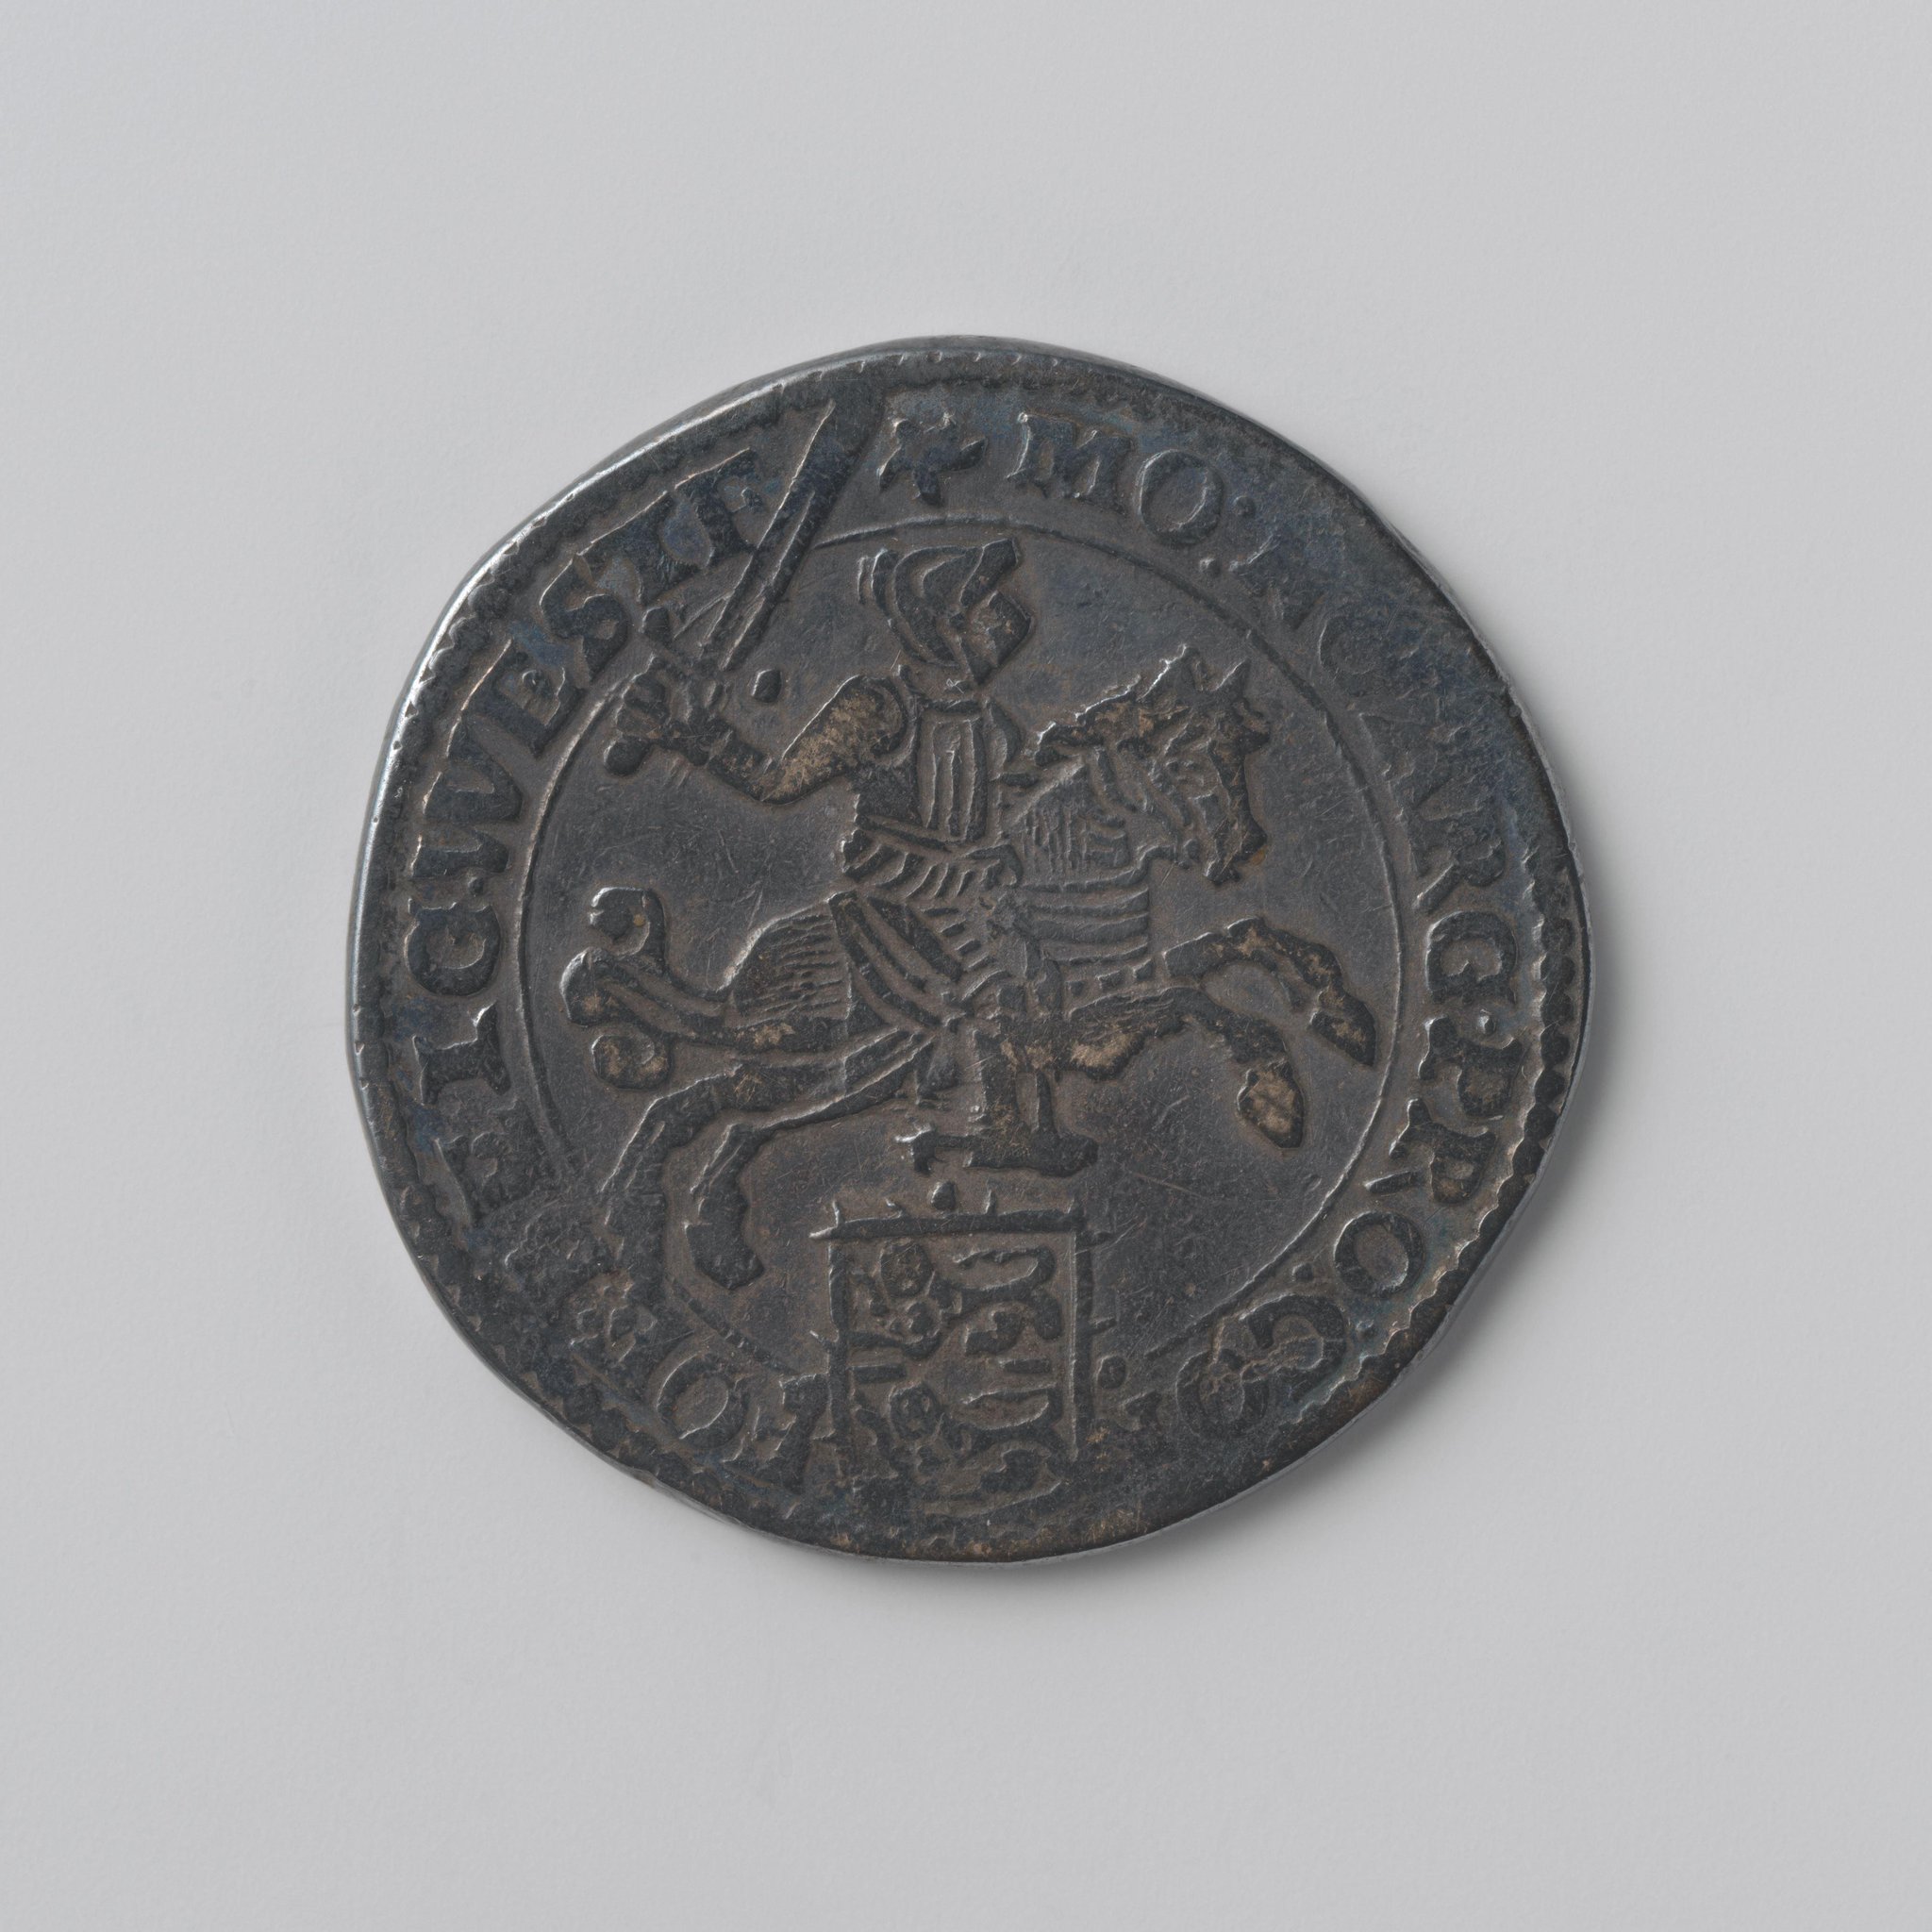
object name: coin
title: West-Friesland, halve zilveren rijder, 1662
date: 1662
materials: silver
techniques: striking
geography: west frisia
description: Zilveren munt. Voorzijde: boven wapenschild van West-Friesland ridder met in rechterhand zwaard naar rechts. Keerzijde: door twee leeuwen gehouden gekroond generaliteitswapenschild. Boven kroon jaartal.